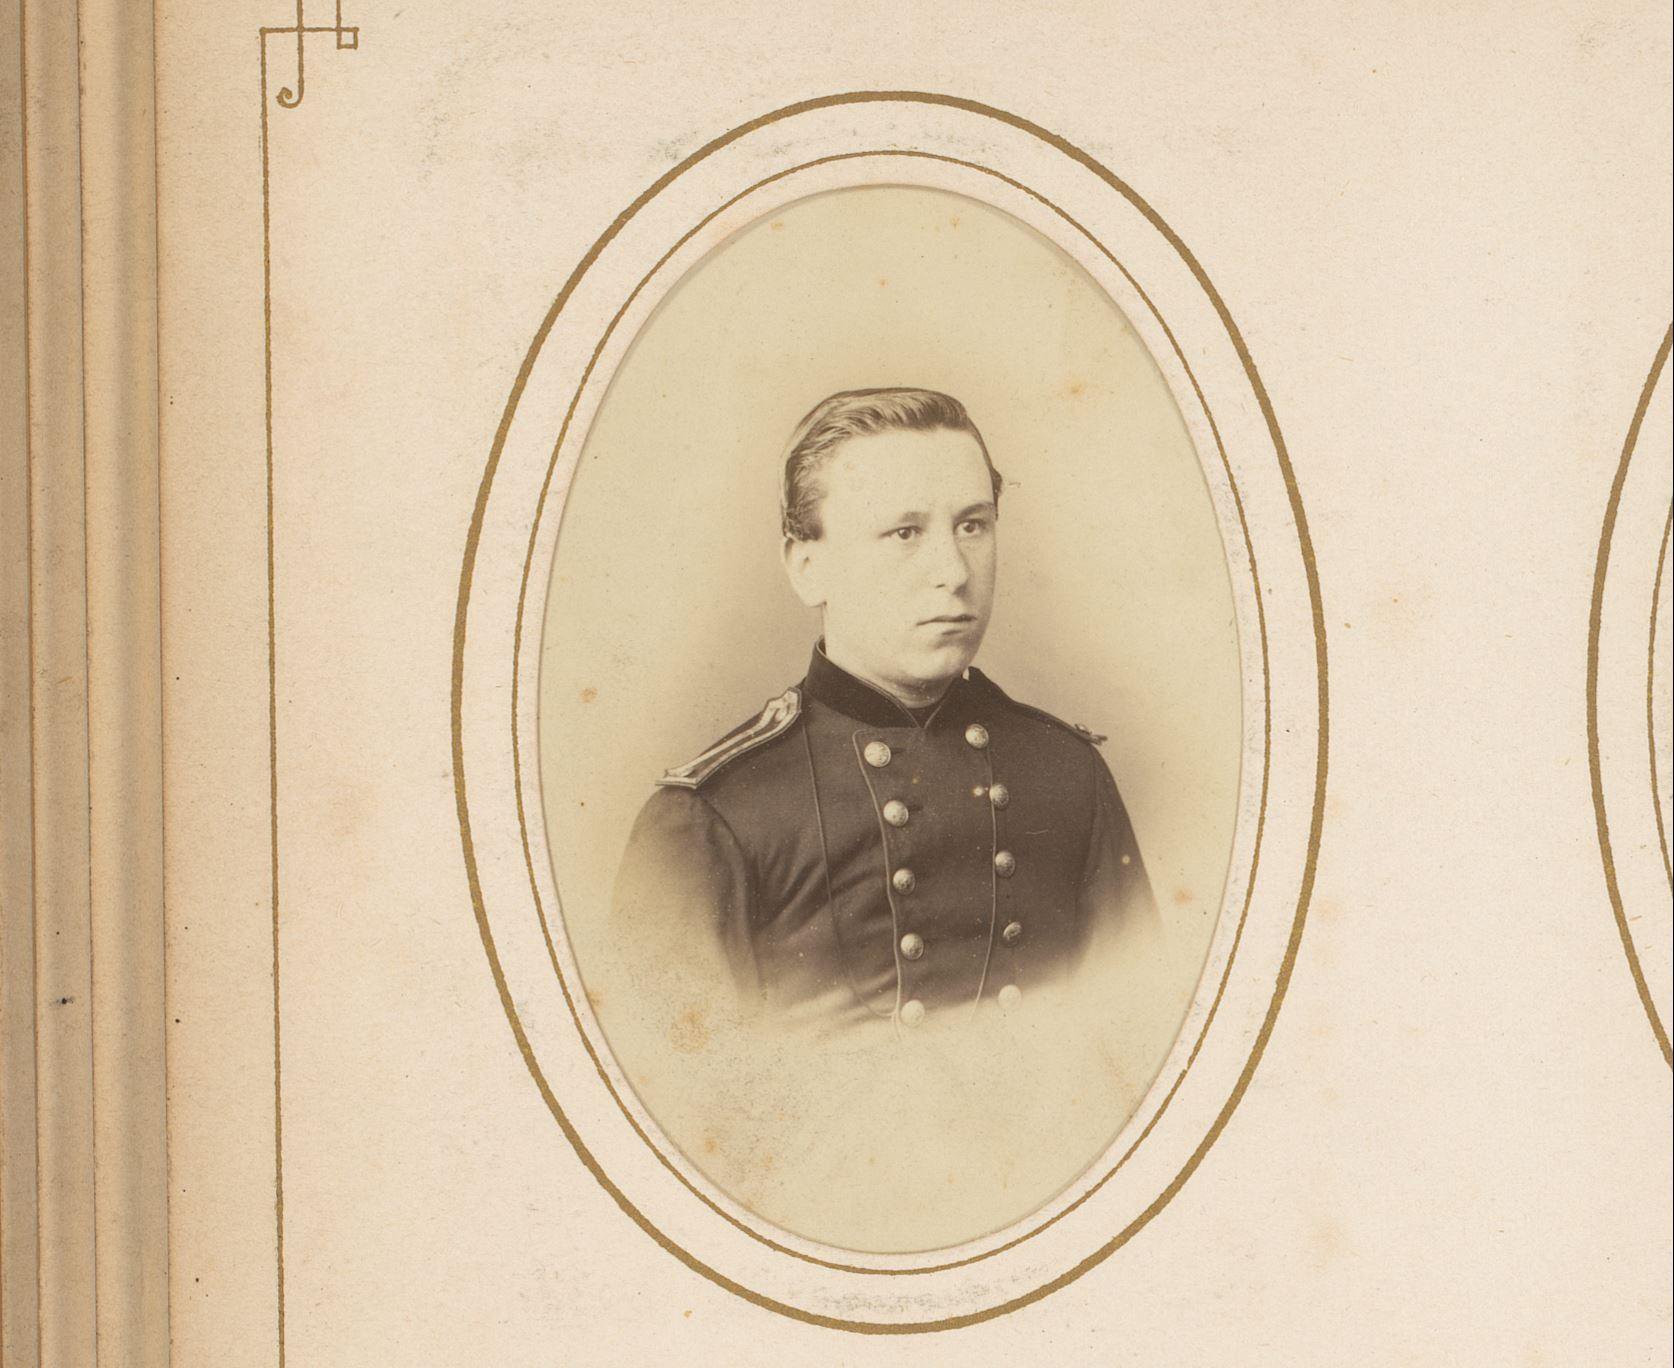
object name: album leaf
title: Portret van een jonge man in militair uniform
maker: albert baron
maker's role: fotograaf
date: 1863-1865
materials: cardboard, photographic support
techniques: albumen print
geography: brussels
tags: historical persons, youth, adolescent, (military) uniforms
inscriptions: inscription: ‘ALBERT BARON/ PHOTOGRAPHE/ RUE DE L'ECUYER, 38./ en face le Théatre/ des Galeries./ BRUXELLES.’